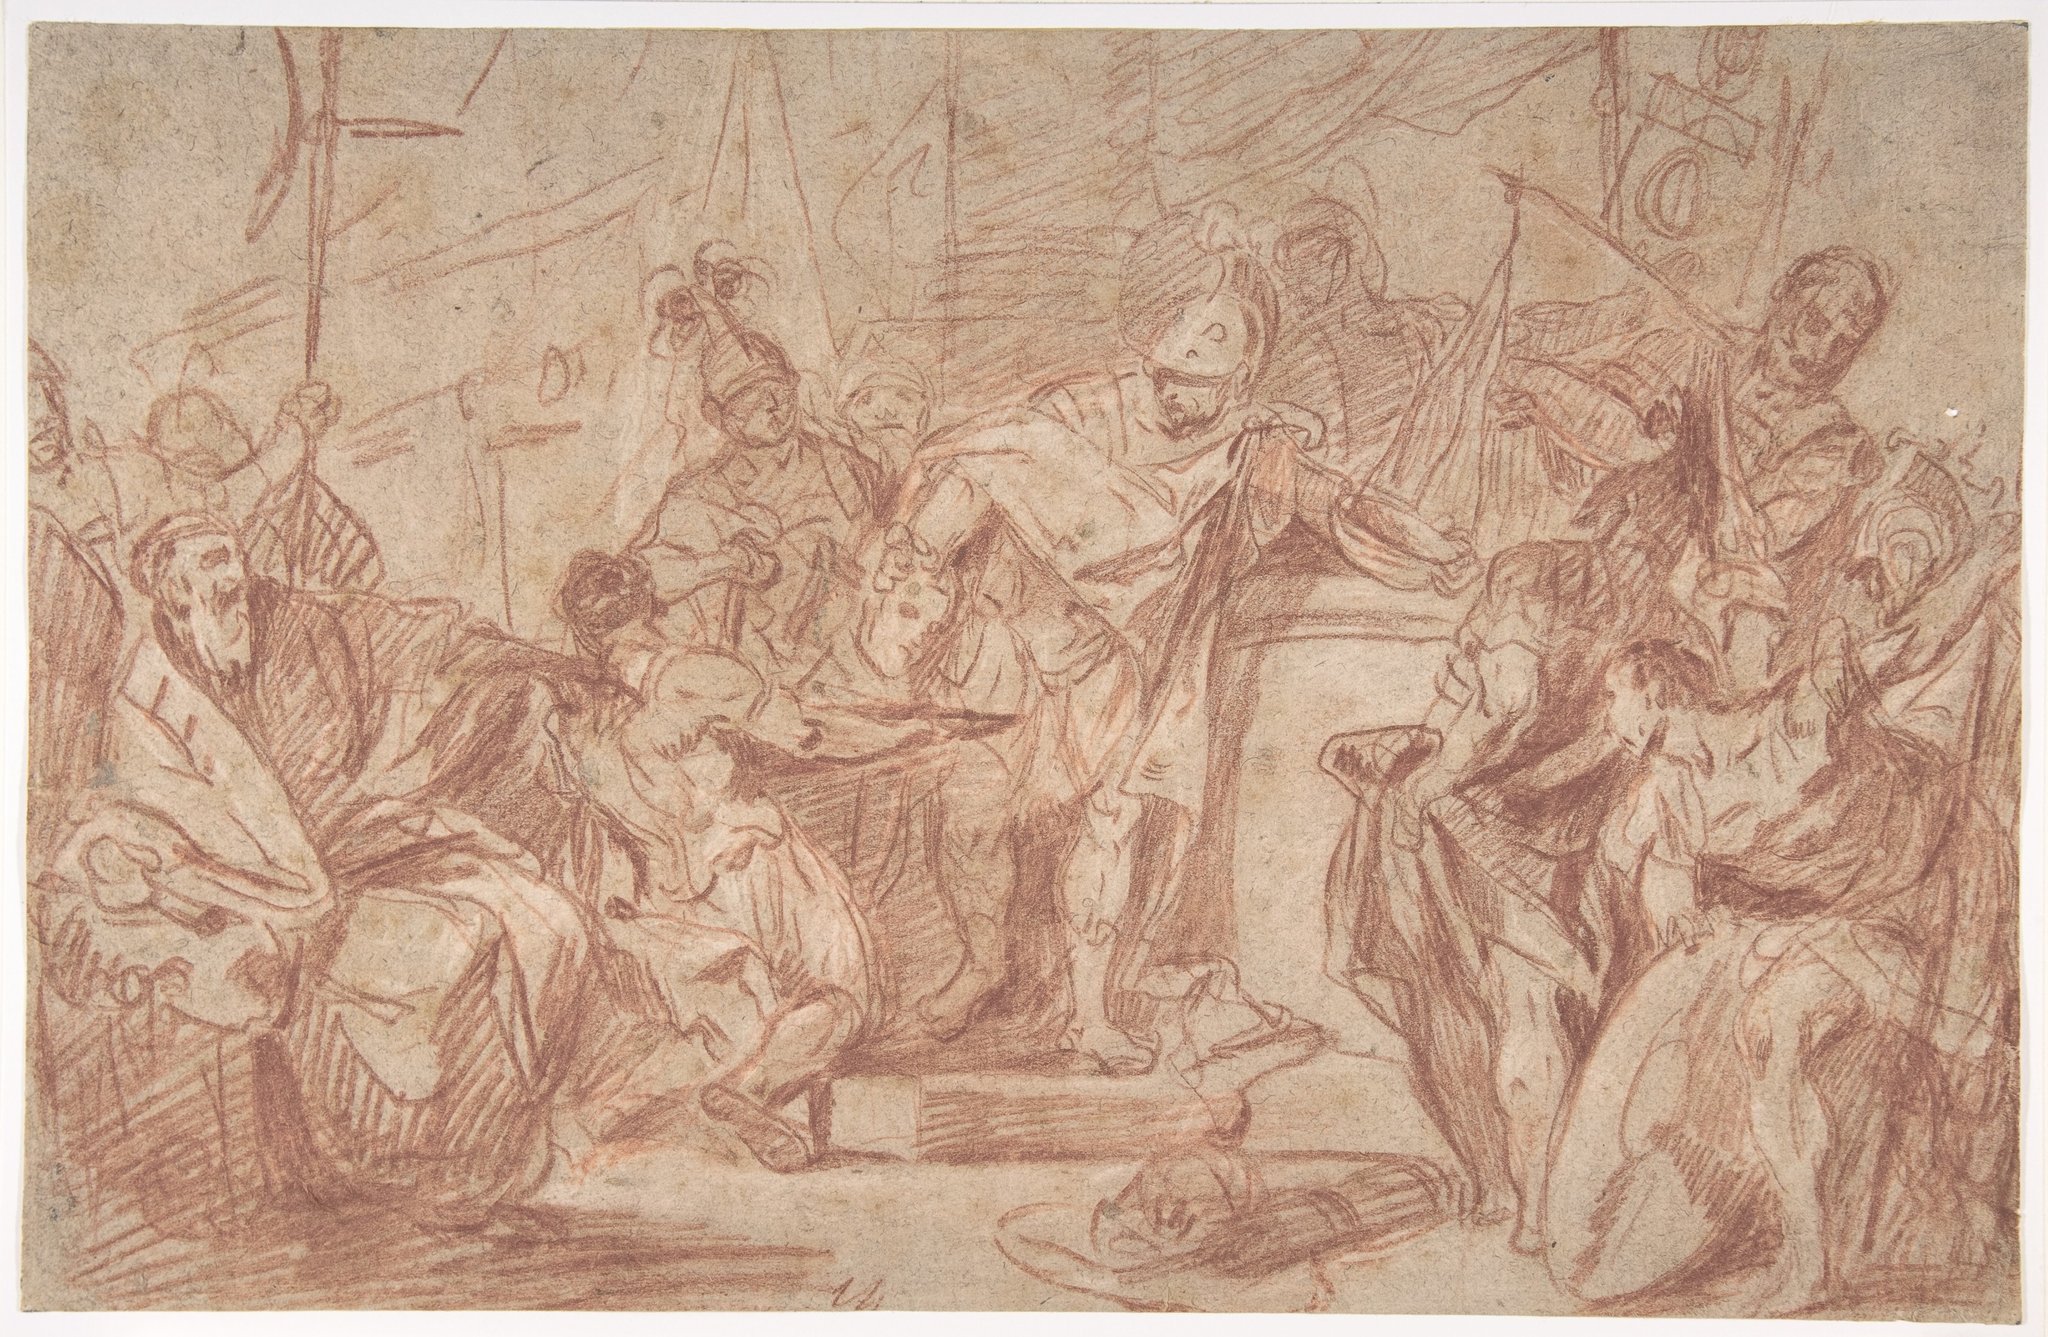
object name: drawing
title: Scene from Ancient History (recto); Leg and Arm of a Nude Male Figure (verso)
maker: nicola marcola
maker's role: artist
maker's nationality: italian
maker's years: 1738-1770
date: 1738-1770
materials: chalk, paper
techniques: highlighting, stumping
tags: men,male nudes